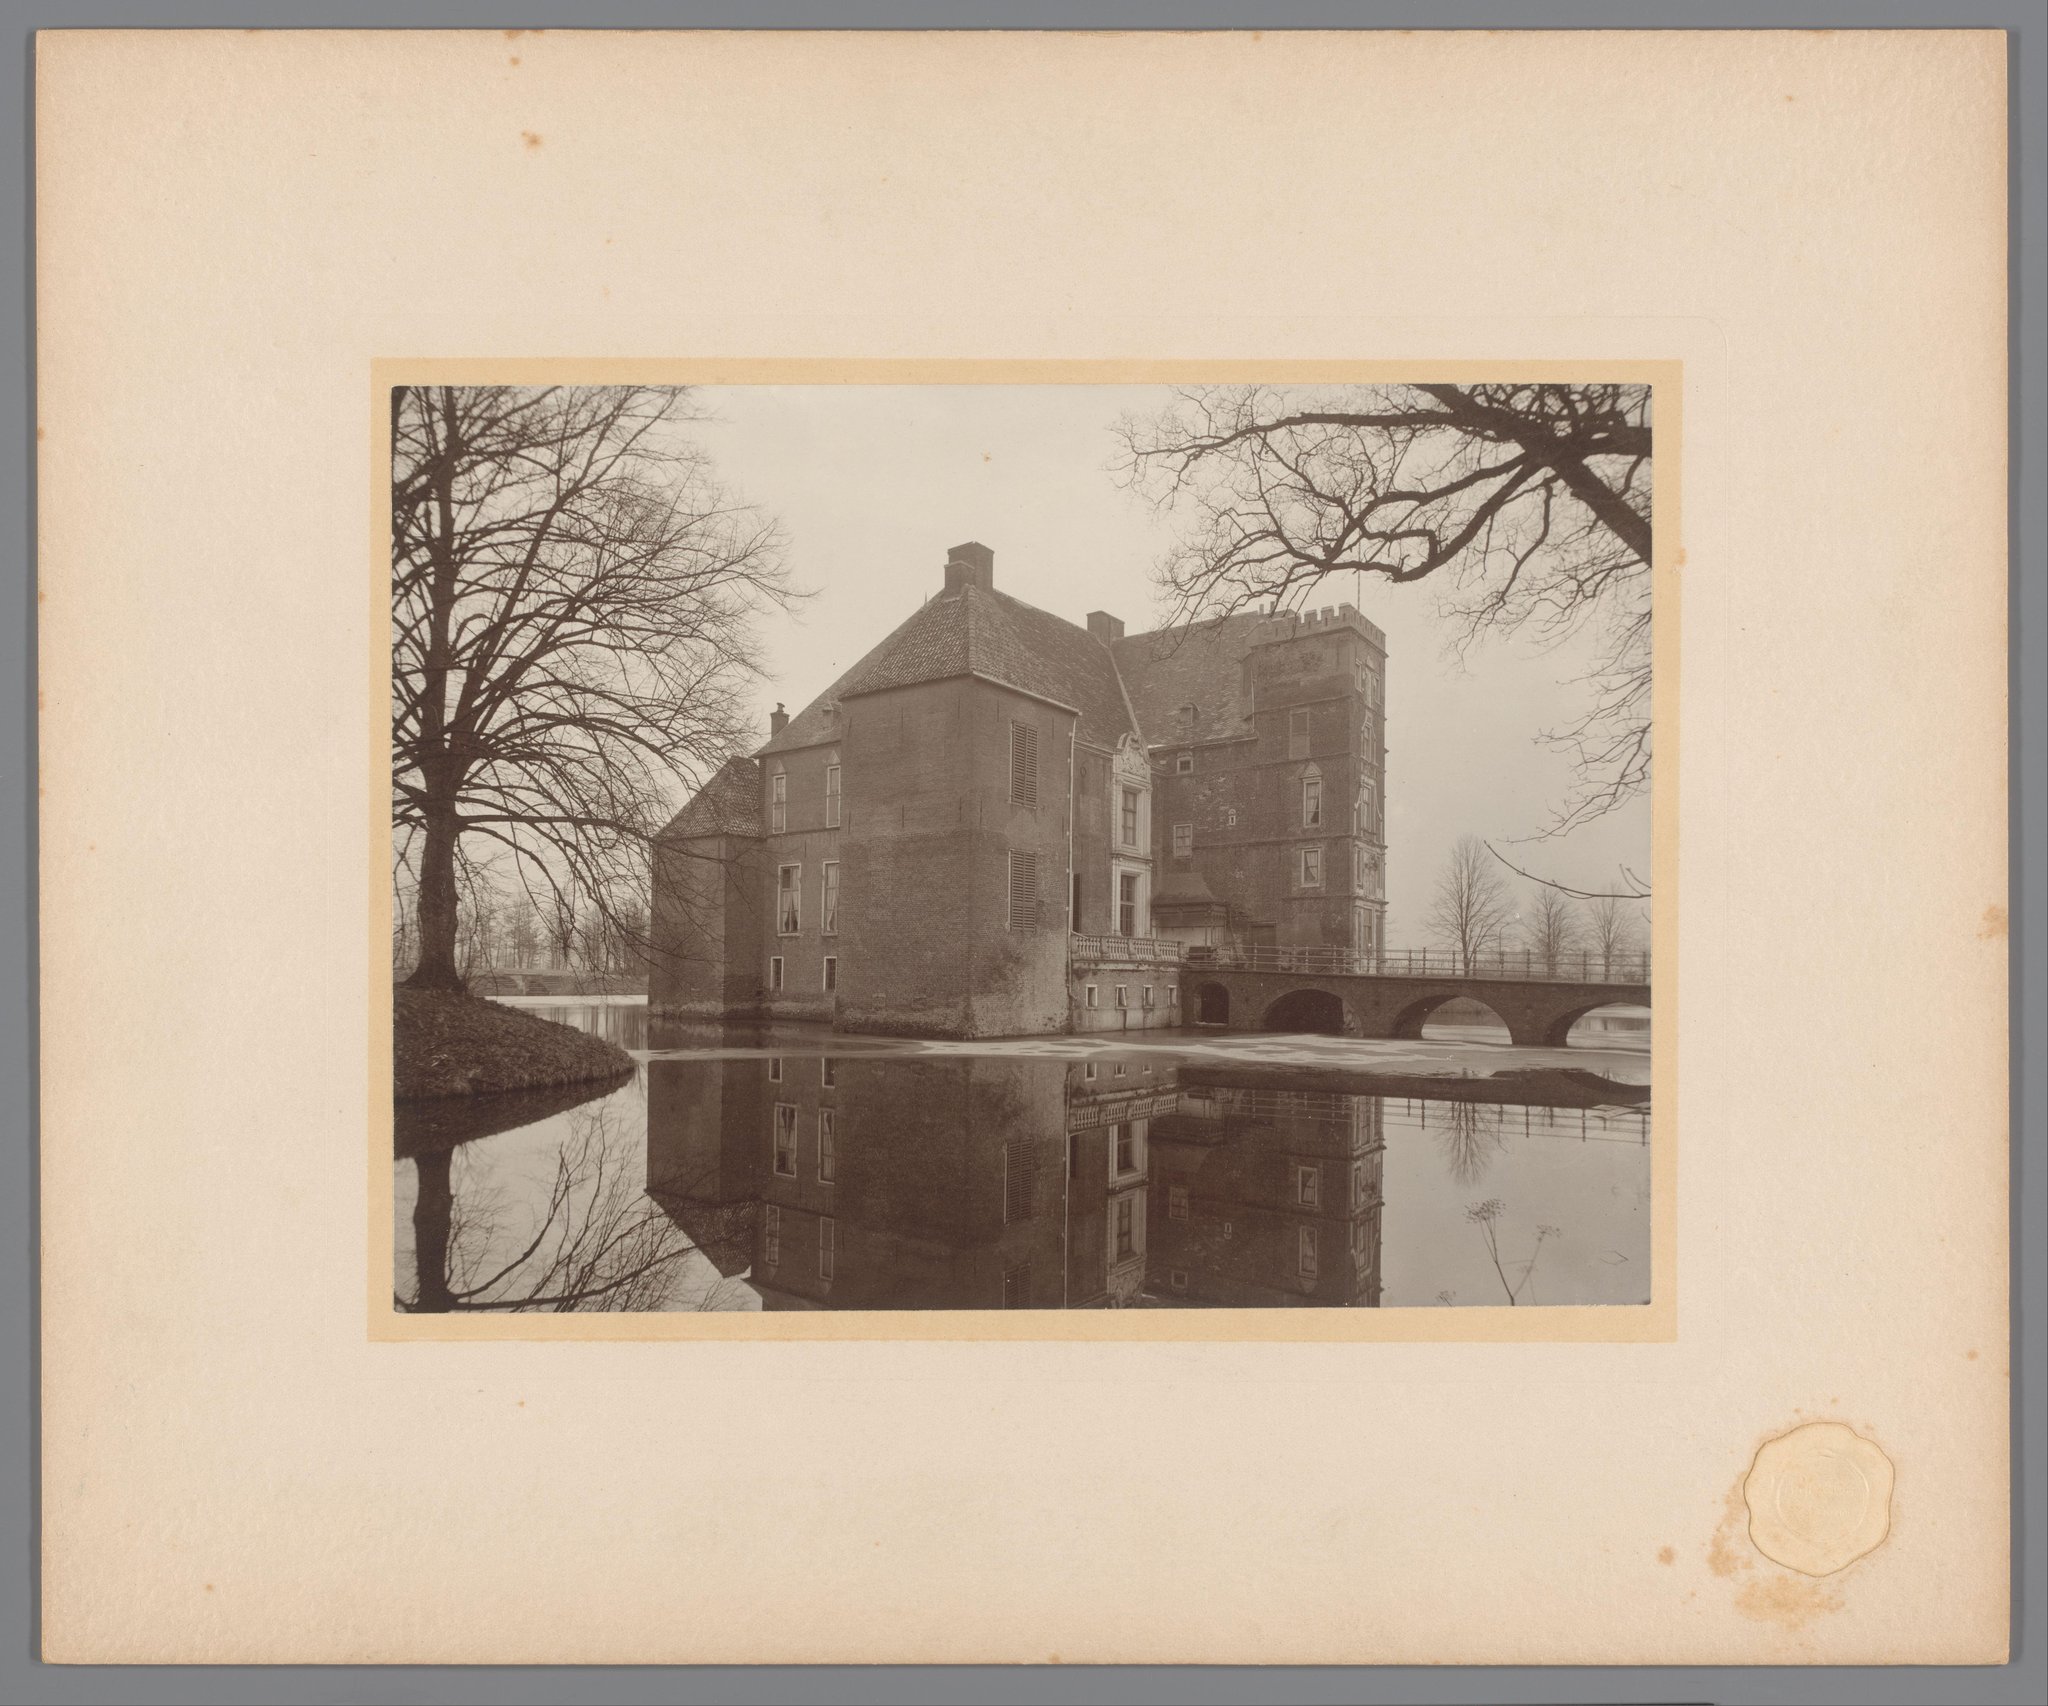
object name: photograph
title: Gezicht op Kasteel Cannenburch te Vaassen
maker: henri bickhoff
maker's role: fotograaf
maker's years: 1866-1933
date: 1905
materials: cardboard, photographic support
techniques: collodion silver print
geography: vaassen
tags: castle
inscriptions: inscription: ‘H. Bickhoff/ Amsterdam’, annotation: ‘Kasteel Cannenburgh/ (Vaassen) Ebe/ Erven J. [...] 1972’